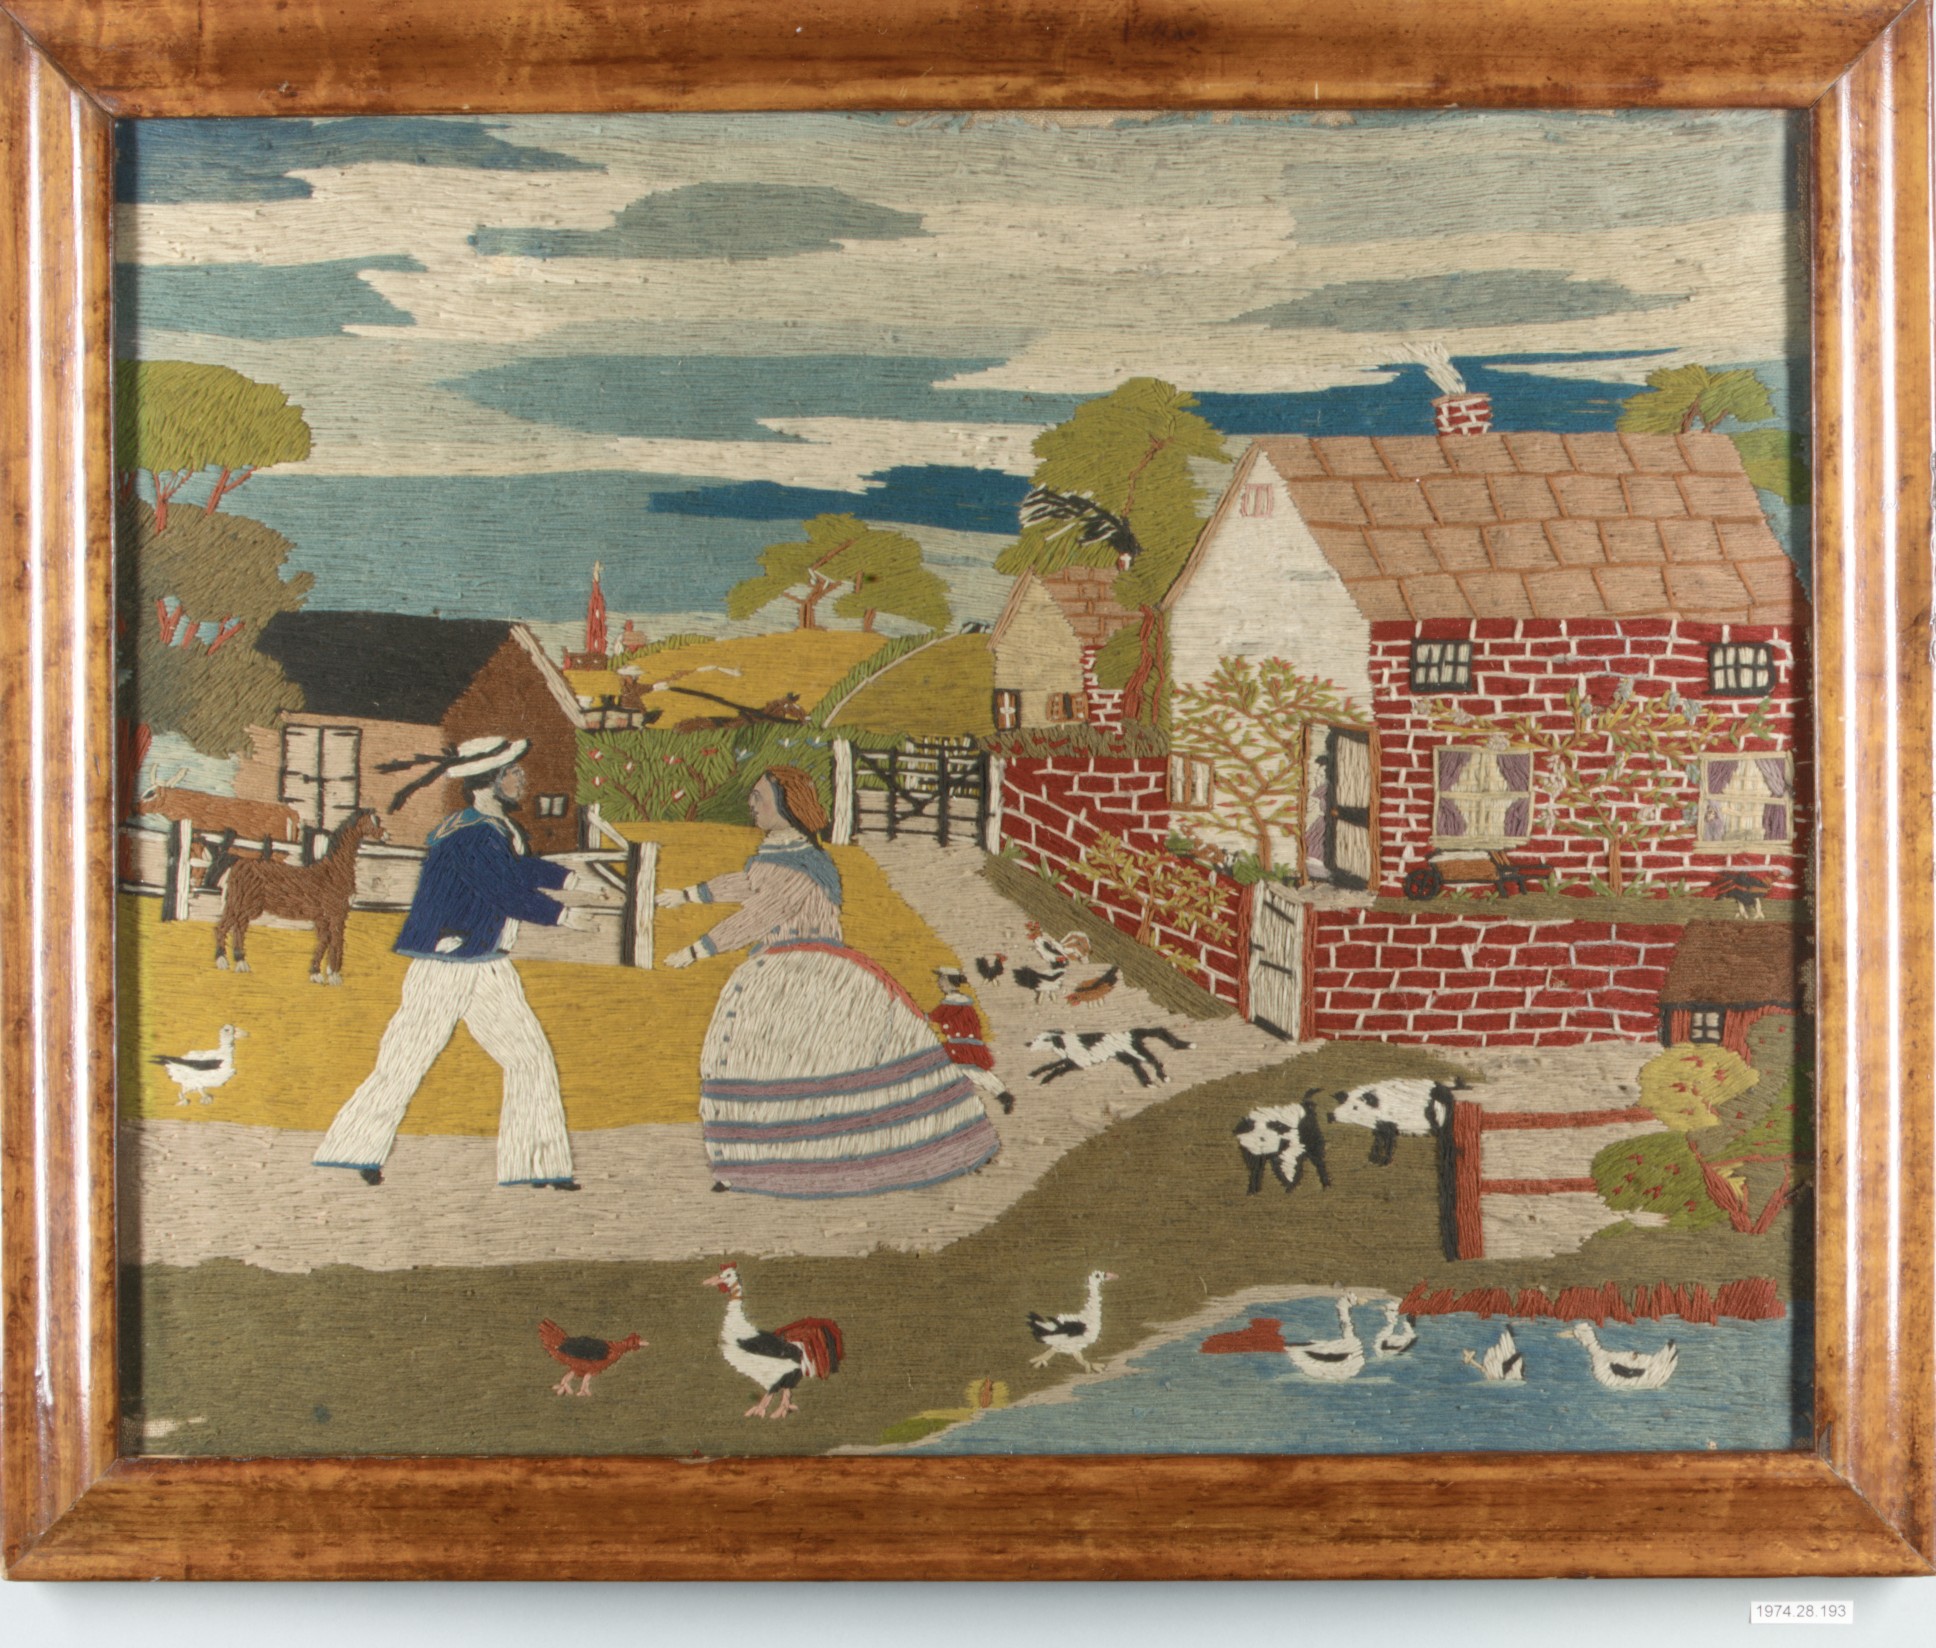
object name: embroidered picture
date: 1801-1900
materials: wool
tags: birds,ducks,houses,men,women,dogs,horses